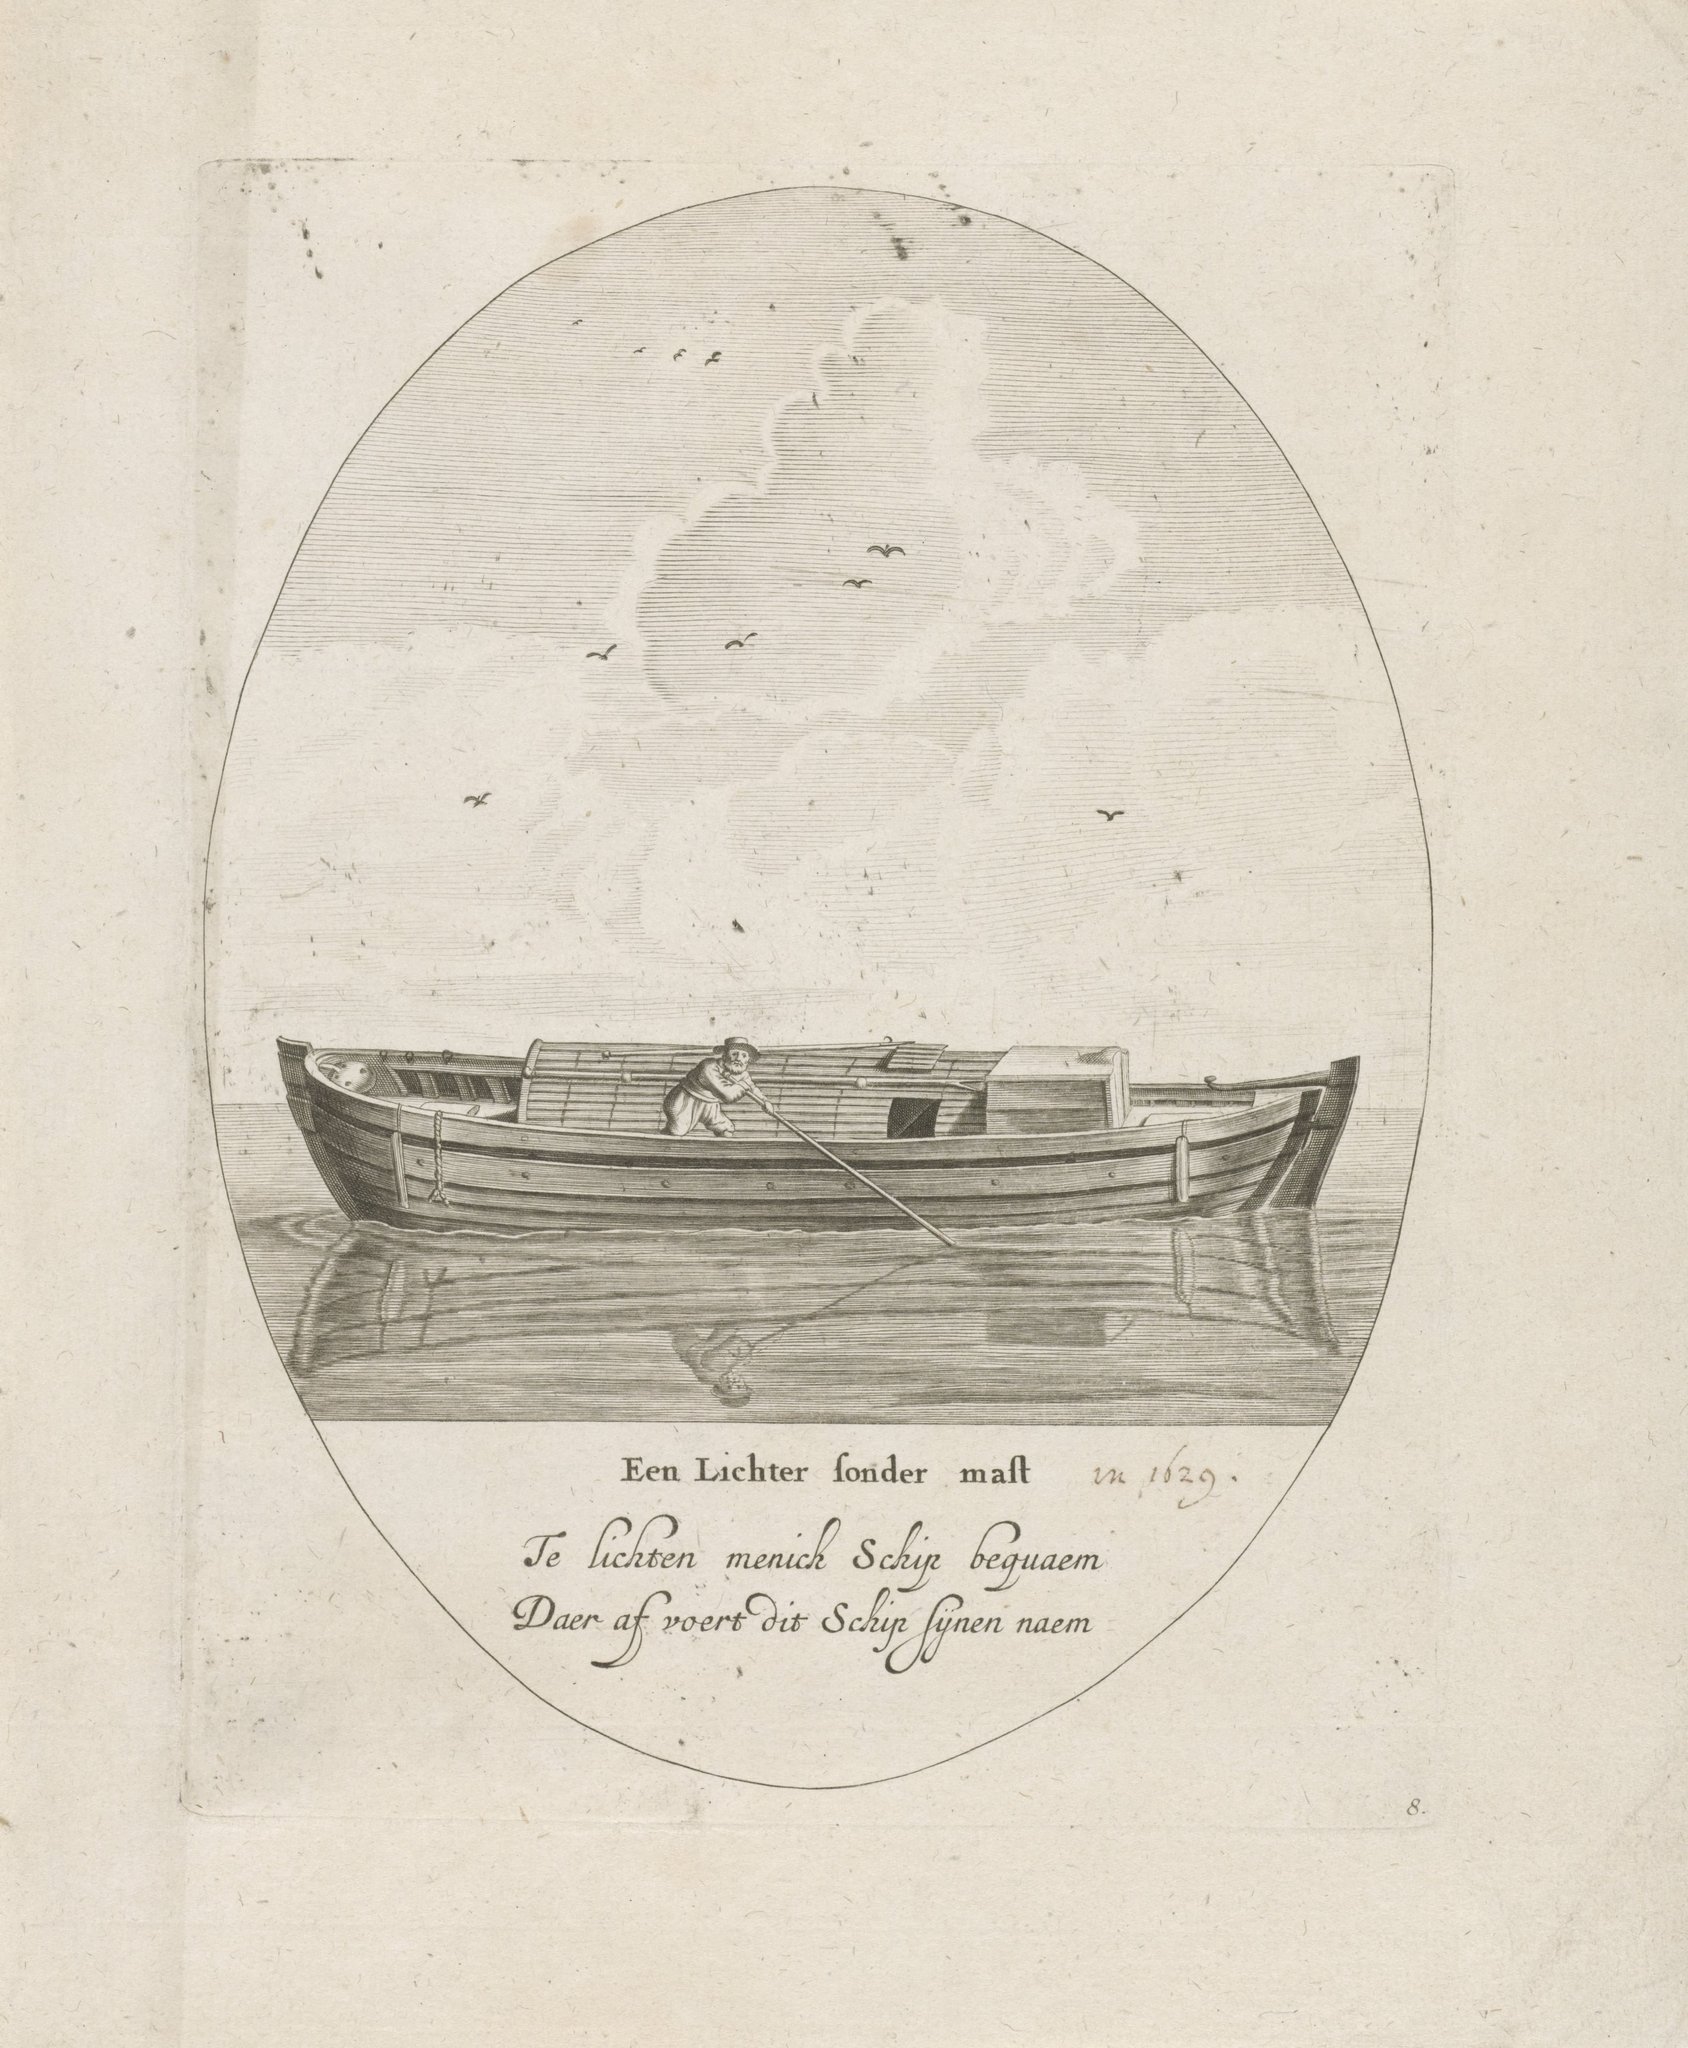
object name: print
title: Lichter zonder mast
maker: dirk eversen lons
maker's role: print maker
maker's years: 1599-1686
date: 1609-1686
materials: paper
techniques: engraving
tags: sailing-ship, sailing-boat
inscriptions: collector's mark: Lugt 2760, inscription: ‘in 1629.’, collector's mark: Lugt 2228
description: Een lichter zonder mast, door een opvarende vooruit geboomd. Onder de voorstelling een tweeregelig Nederlands vers.